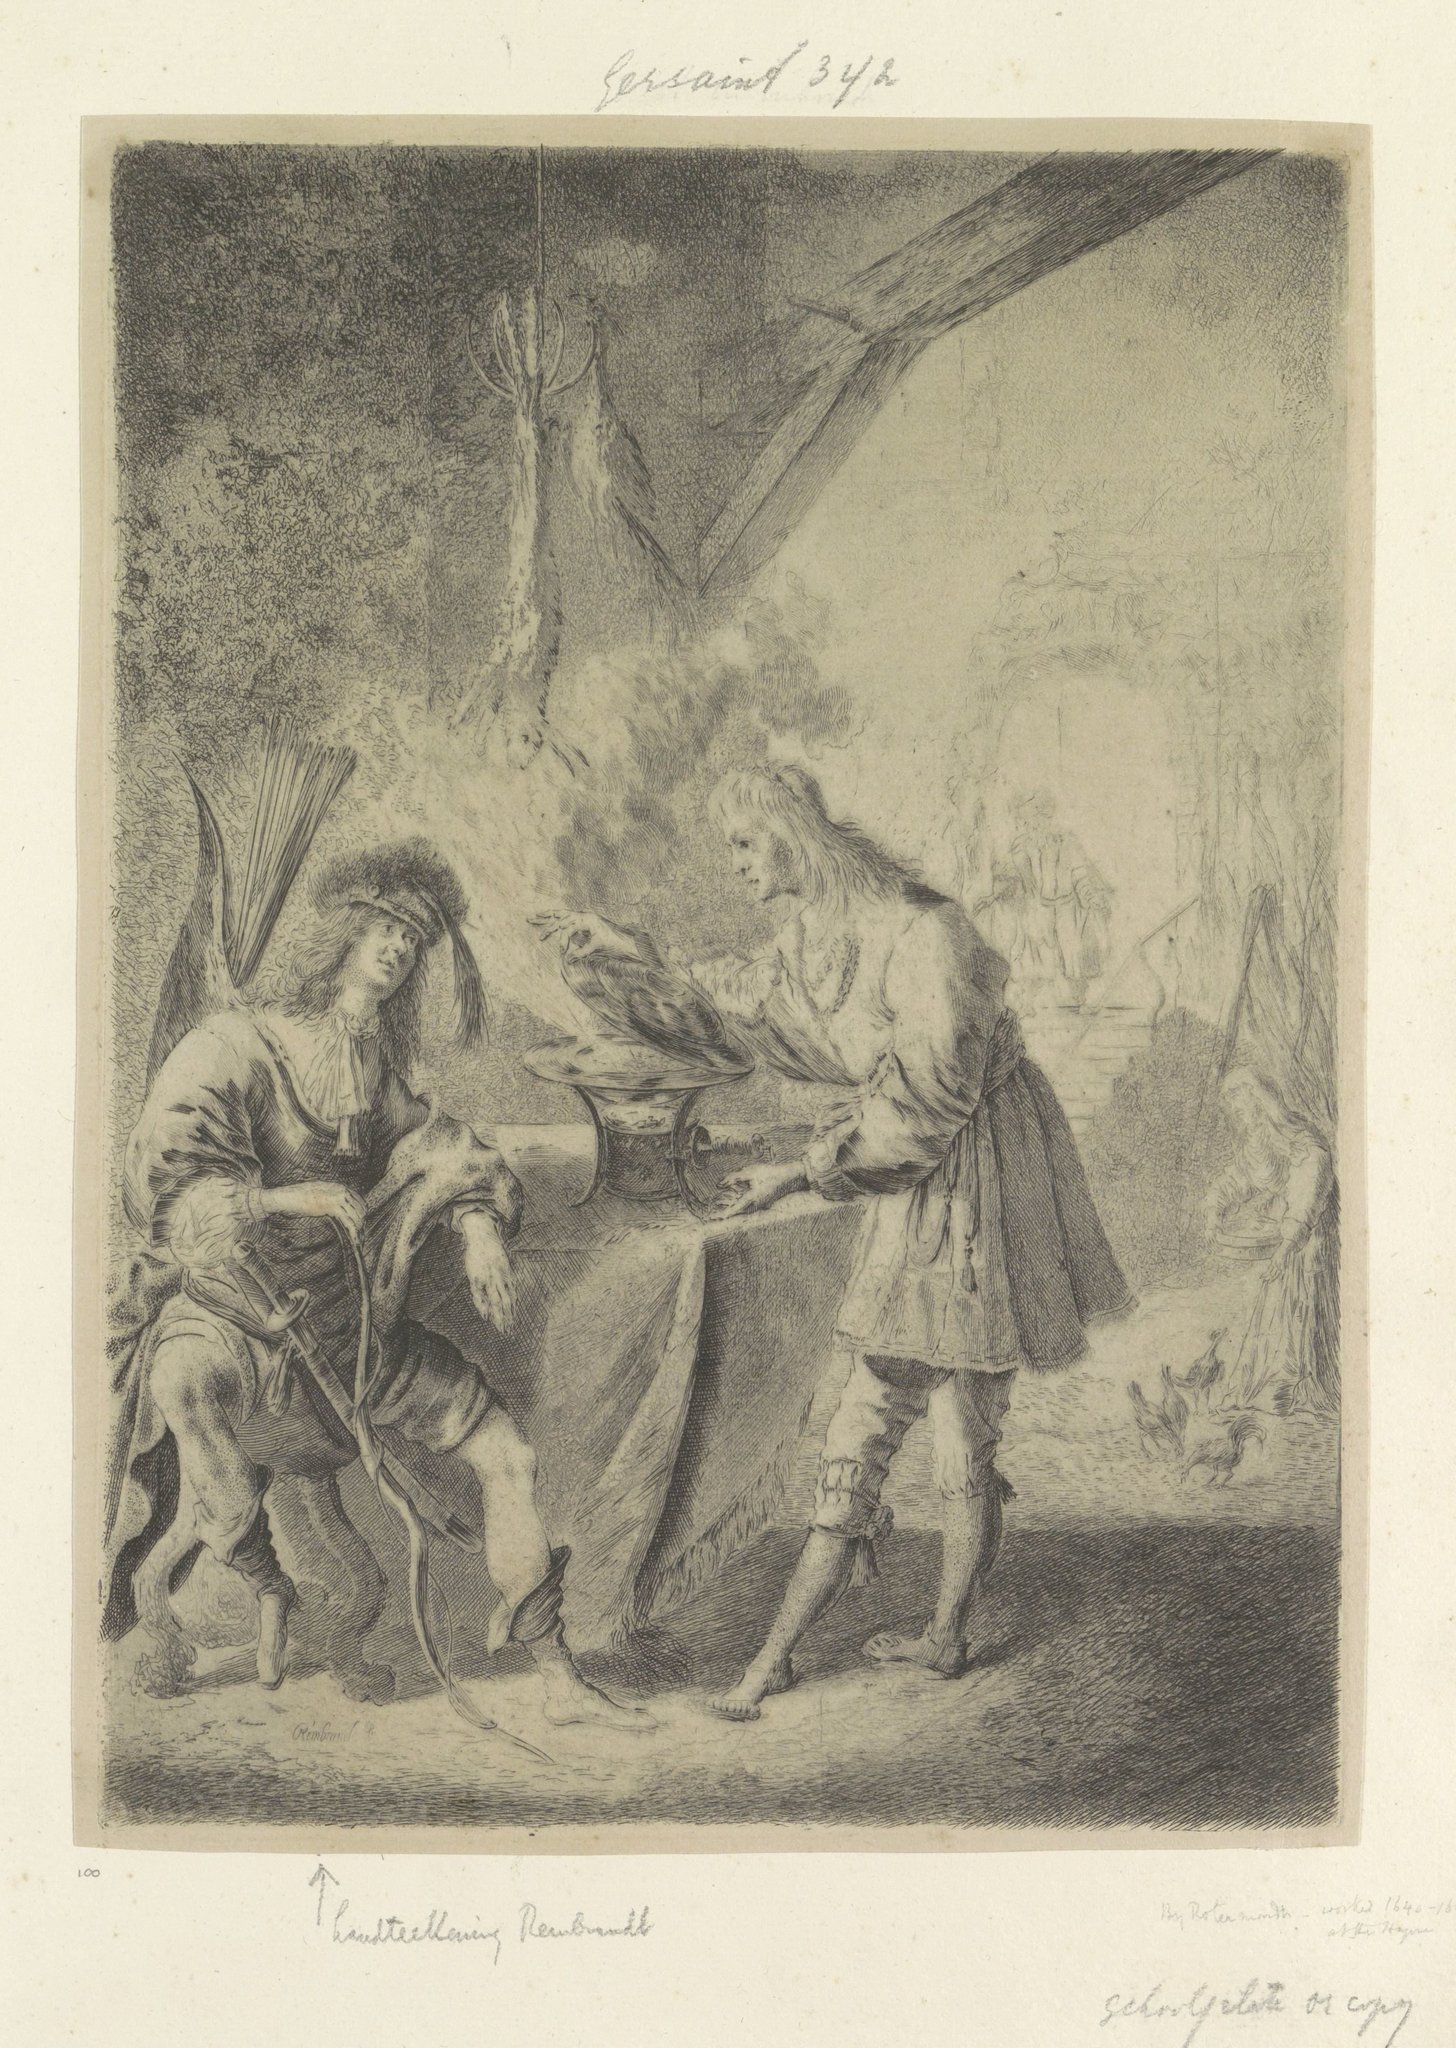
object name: album leaf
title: Recueil de quatre-vingt-cinq estampes originales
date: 1639-1706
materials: paper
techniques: etching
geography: paris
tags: esau, returning hungry from the hunt, sells his first birthright to jacob for a pottage of lentils